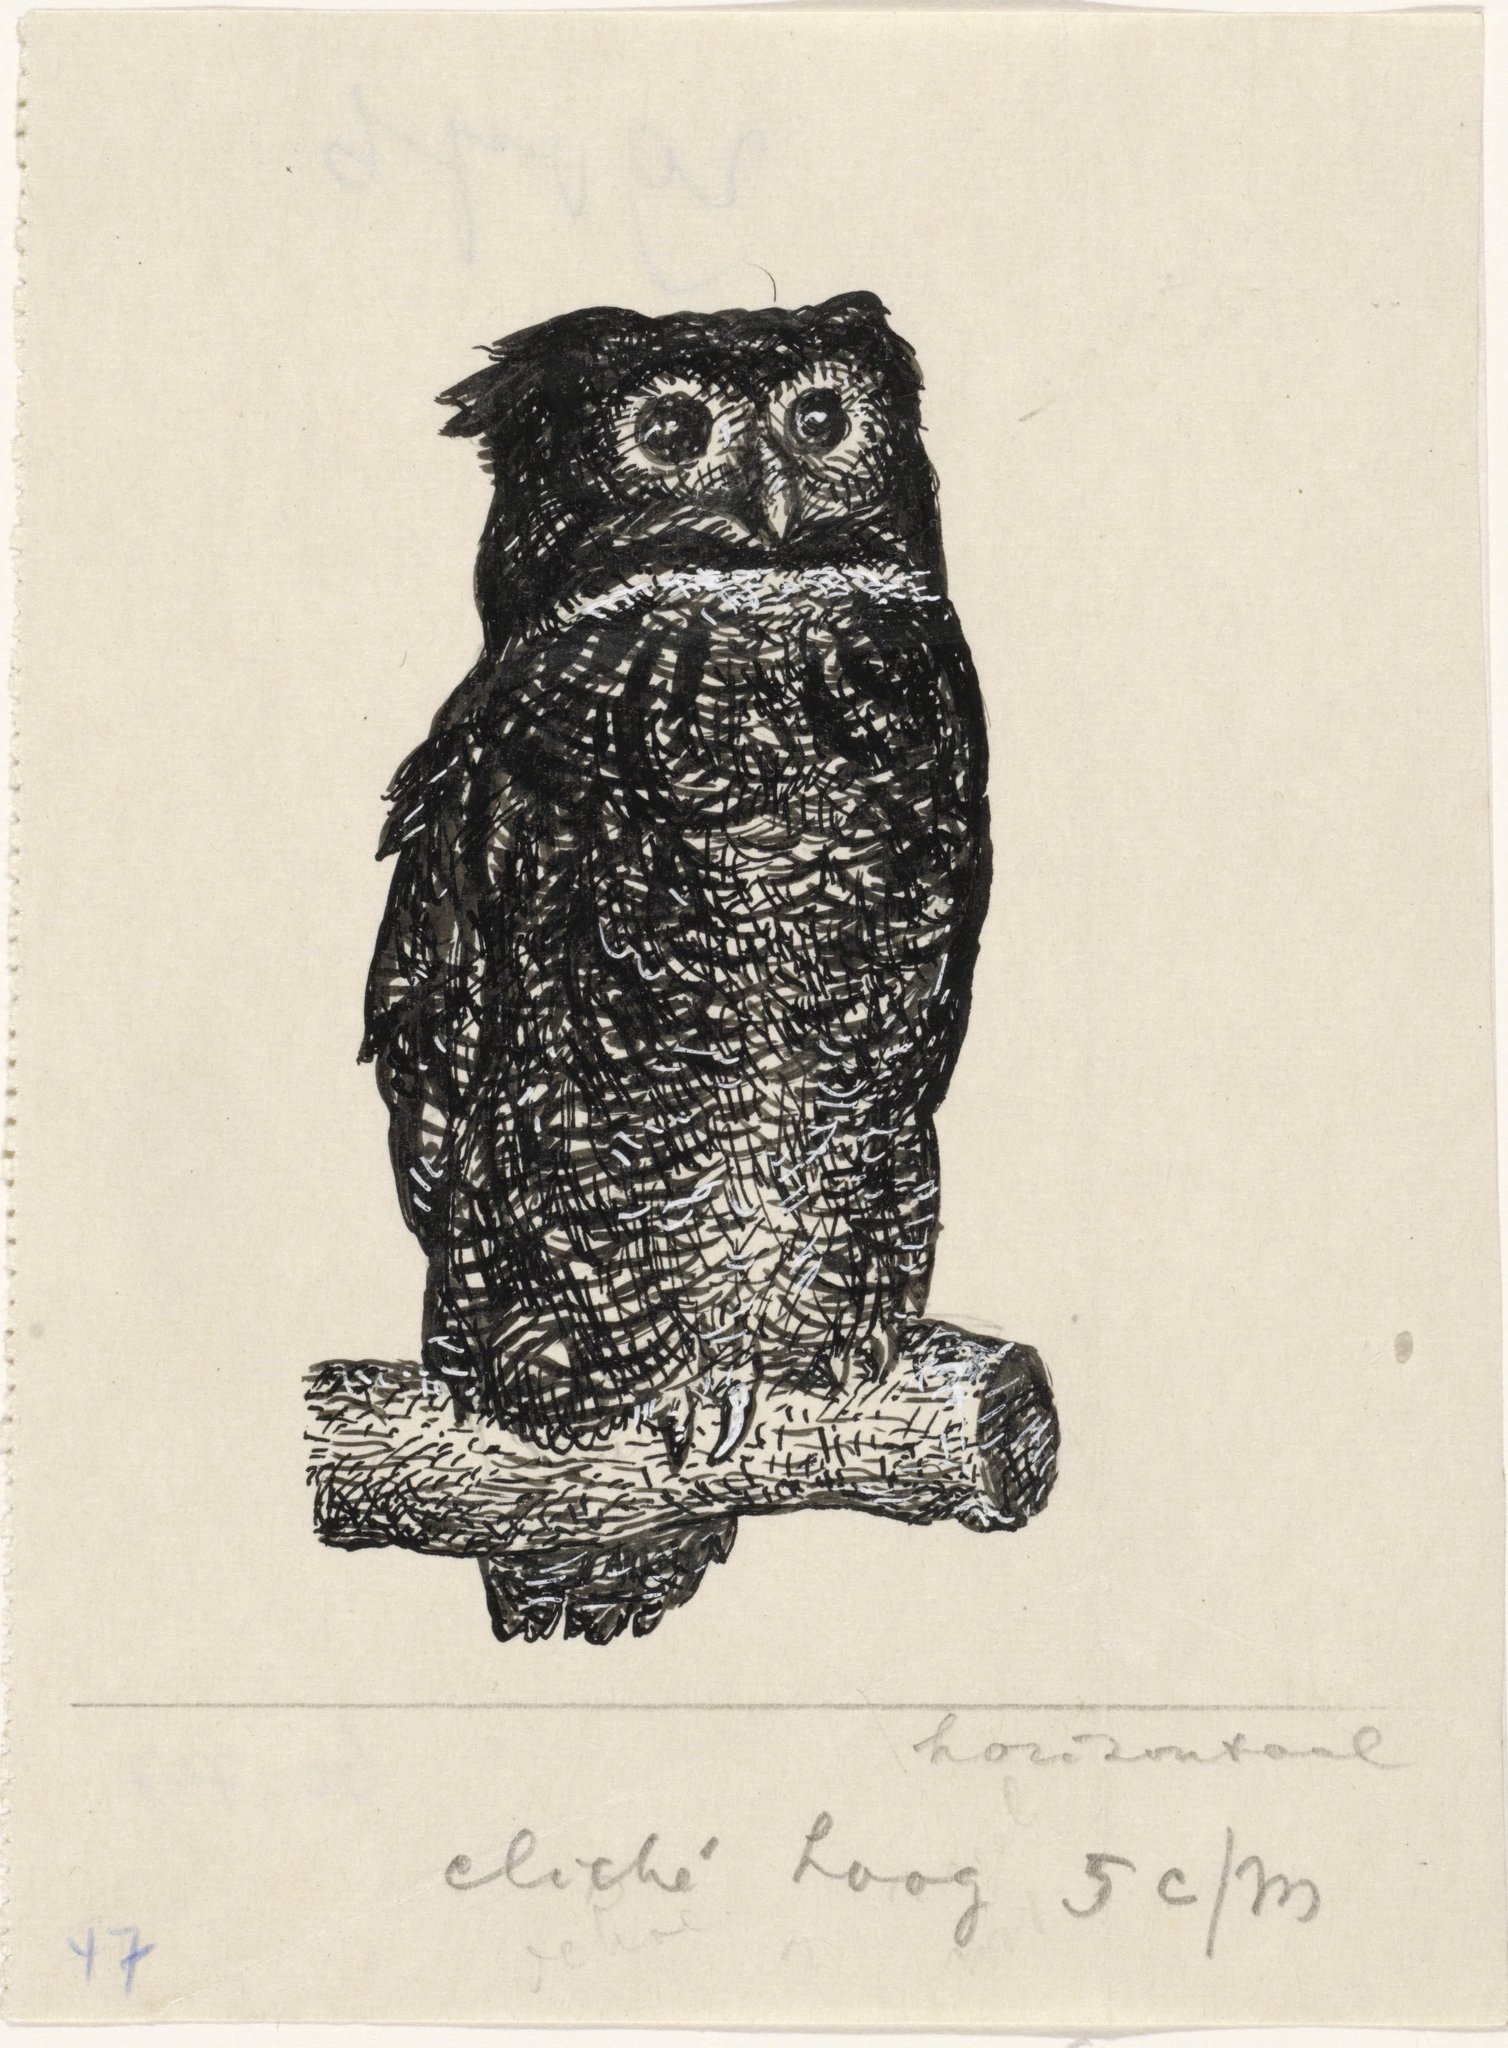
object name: boekillustratie ontwerp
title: Oehoe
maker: leo gestel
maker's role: draughtsman, print maker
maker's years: 1881-1941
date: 1934-1936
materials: paint, ink, paper, pencil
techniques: brush, pen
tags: (cohen, van anarchist tot monarchist) specific works of literature (with author, title), owls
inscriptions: clichéaanwijzing, recto, handgeschreven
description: Ontwerp voor een boekillustratie voor: Cohen, Alexander. Van anarchist tot monarchist. Amsterdam: De Steenuil, 1936.